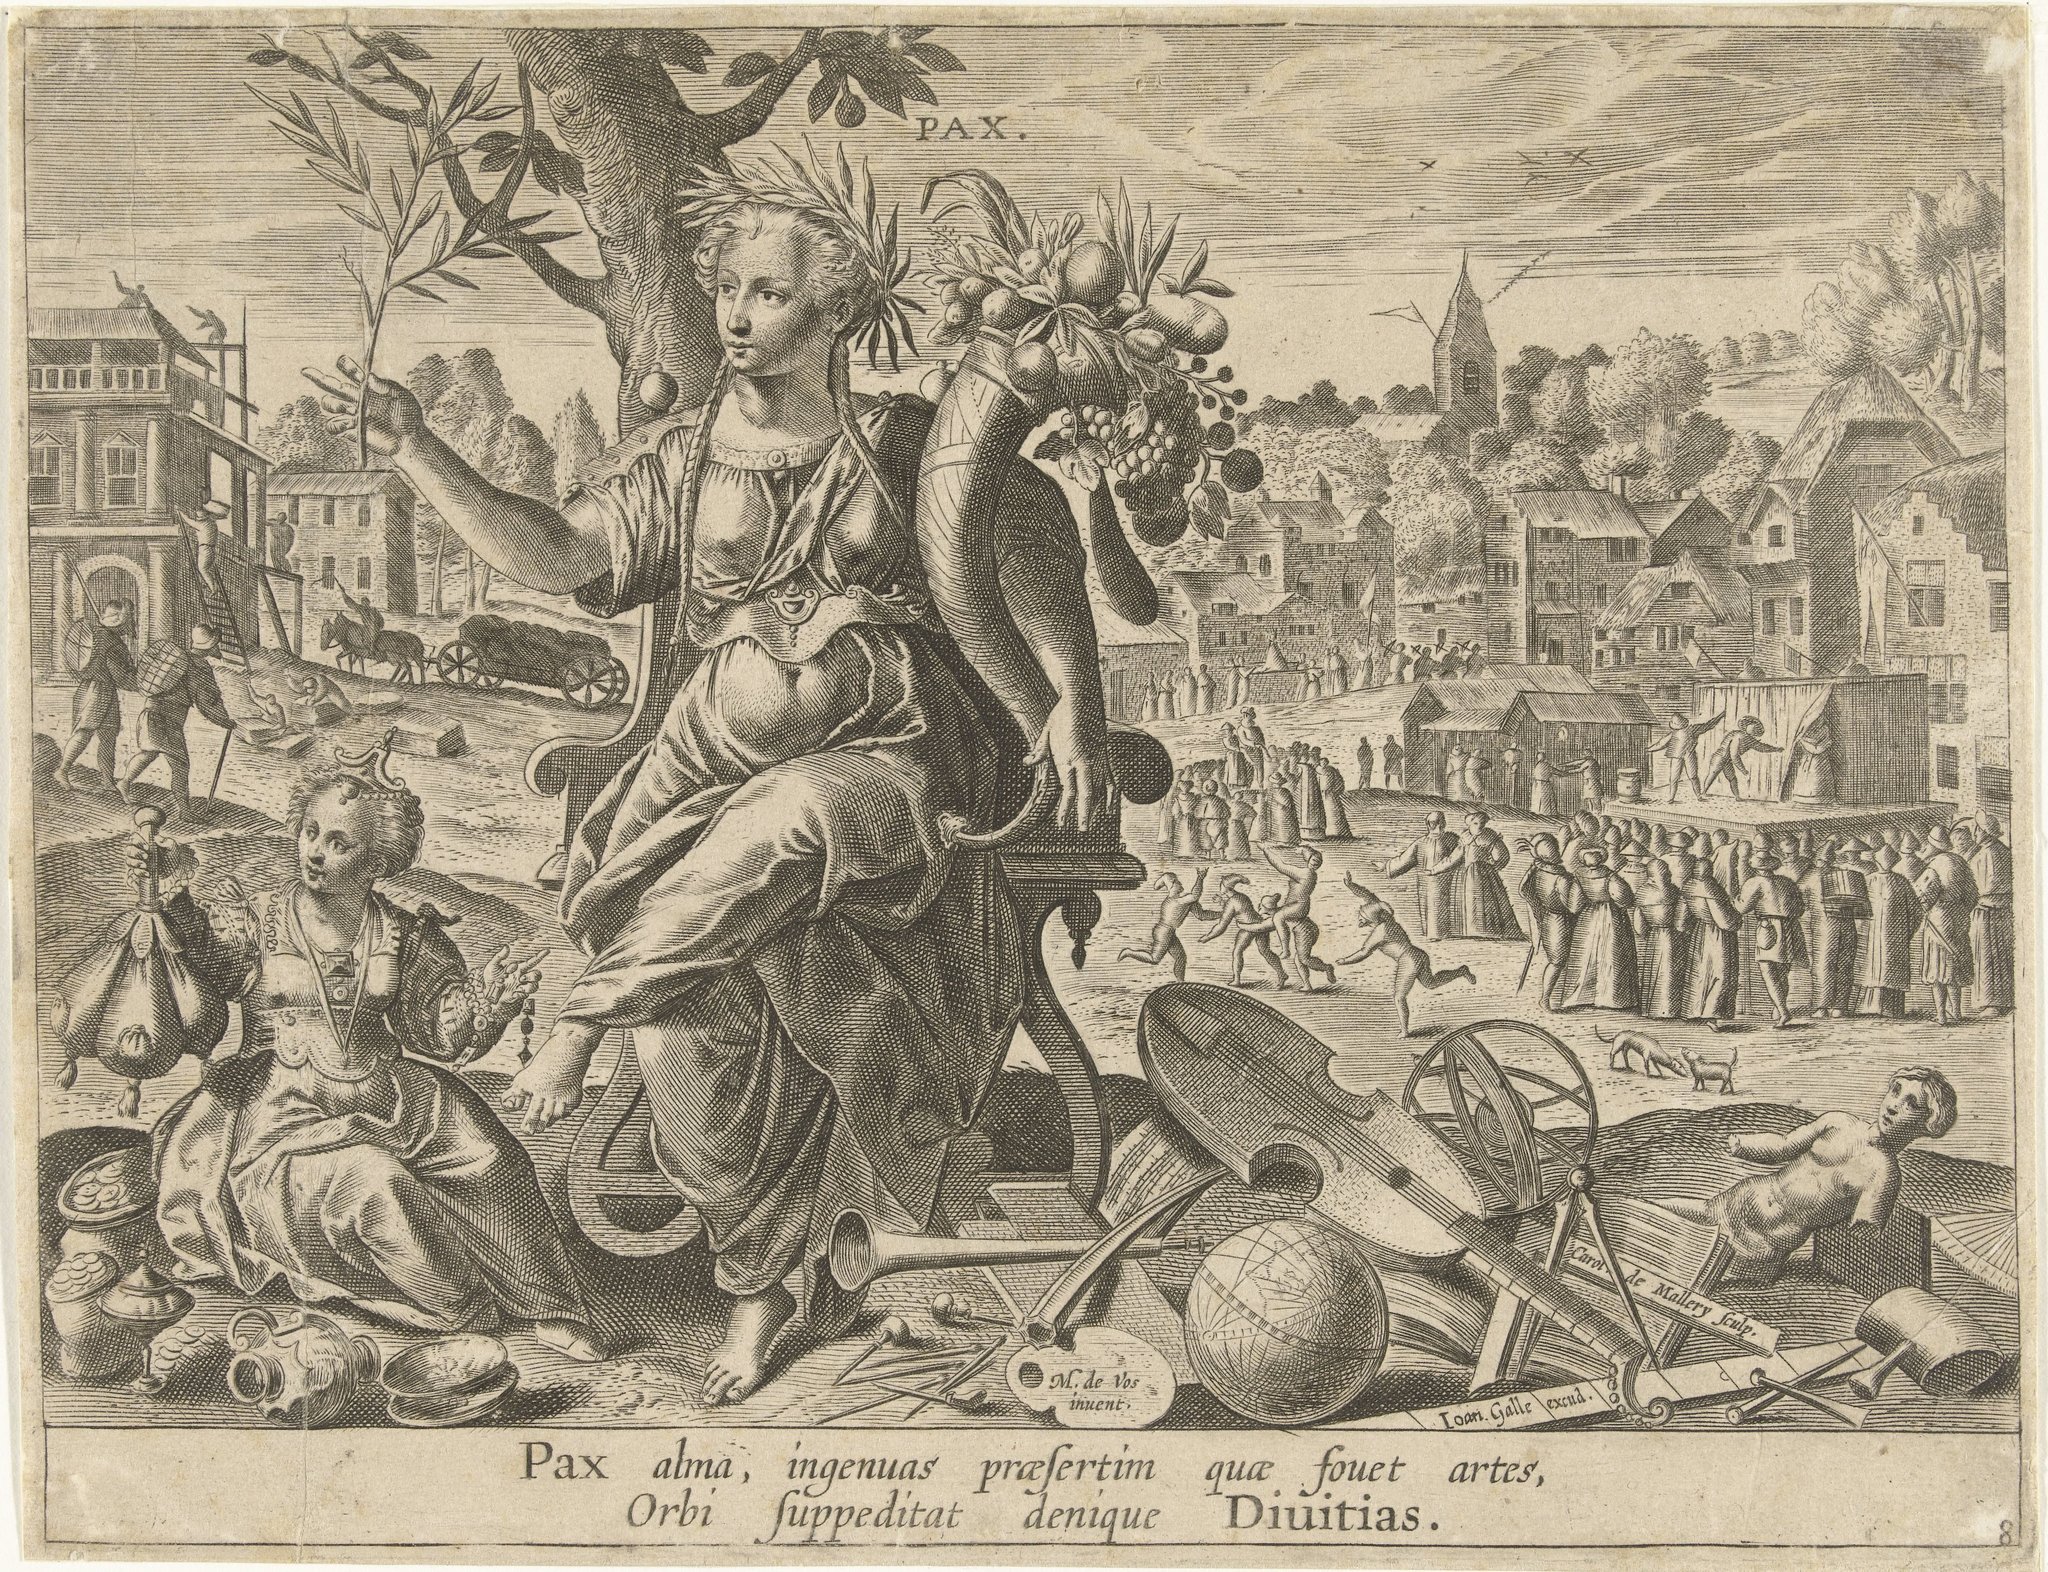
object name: print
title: Vrede brengt Weelde voort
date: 1610-1635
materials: paper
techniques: engraving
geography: antwerp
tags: symbols, allegories of peace, 'pax'; 'pace' (ripa), wealth, opulence; 'opulenza', 'richezza' (ripa), building-site, the liberal arts represented otherwise, e.g. by emblems, symbols, rhetorician's drama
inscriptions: collector's mark: Lugt 2228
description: De personificatie van Vrede (Pax), in haar handen een olijftak en de hoorn van overvloed. Naast haar onder een boom zit de personificatie van Weelde (Divinies), een meisje met een stokkebeurs in de hand. Op de grond liggen de attributen van de kunsten en de wetenschappen. Op de achtergrond rechts een toneelopvoering in de open lucht; links een huis in aanbouw. De prent heeft een Latijns onderschrift en is deel van een serie over de kringloop van het menselijk handelen.